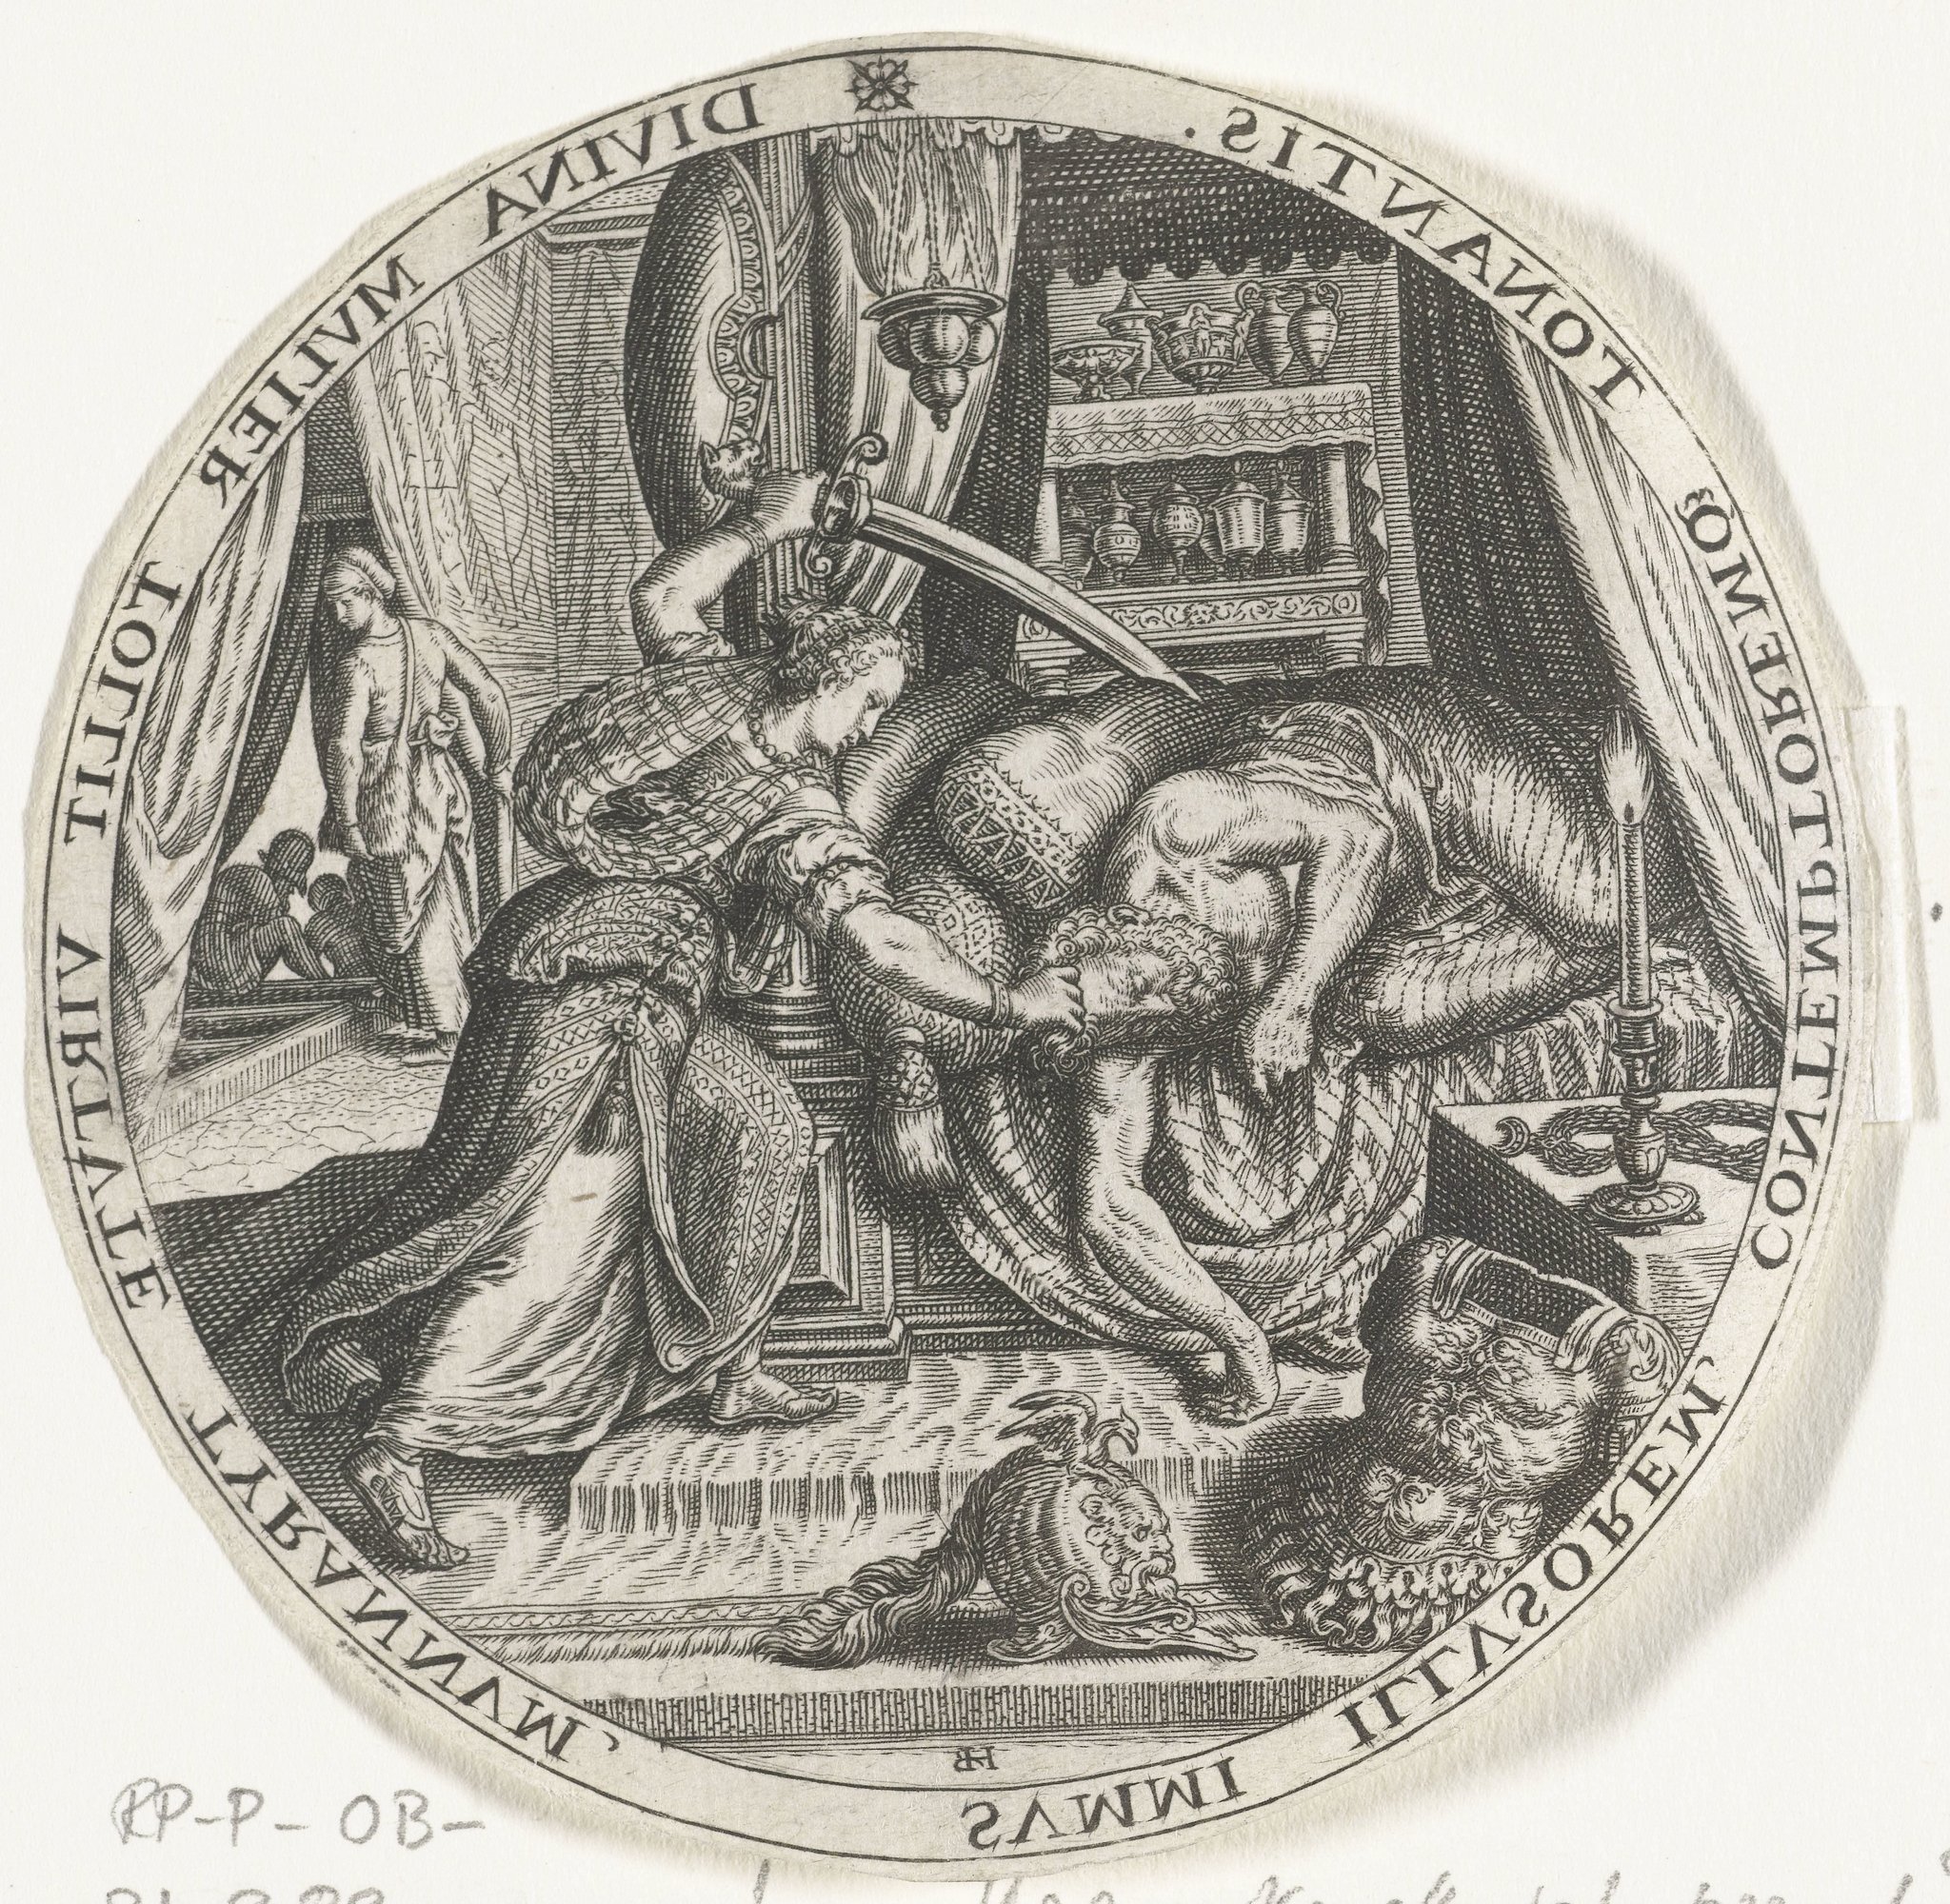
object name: print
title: Judit en Holofernes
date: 1581-1623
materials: paper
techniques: engraving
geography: netherlands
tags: holofernes beheaded by judith with his own sword; the maidservant may be keeping watch, judith and her maidservant in holofernes' camp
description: Judit hakt het hoofd van Holofernes af. Met de ene hand heft zij het zwaard op en met de andere hand houdt zij het hoofd van de slapende Holofernes vast. Rechtsvoor zijn harnas. Linksachter de dienstmaagd die op wacht staat. Tekst in spiegelbeeld, over de gerechtigheid die de tirannie onthoofdt.